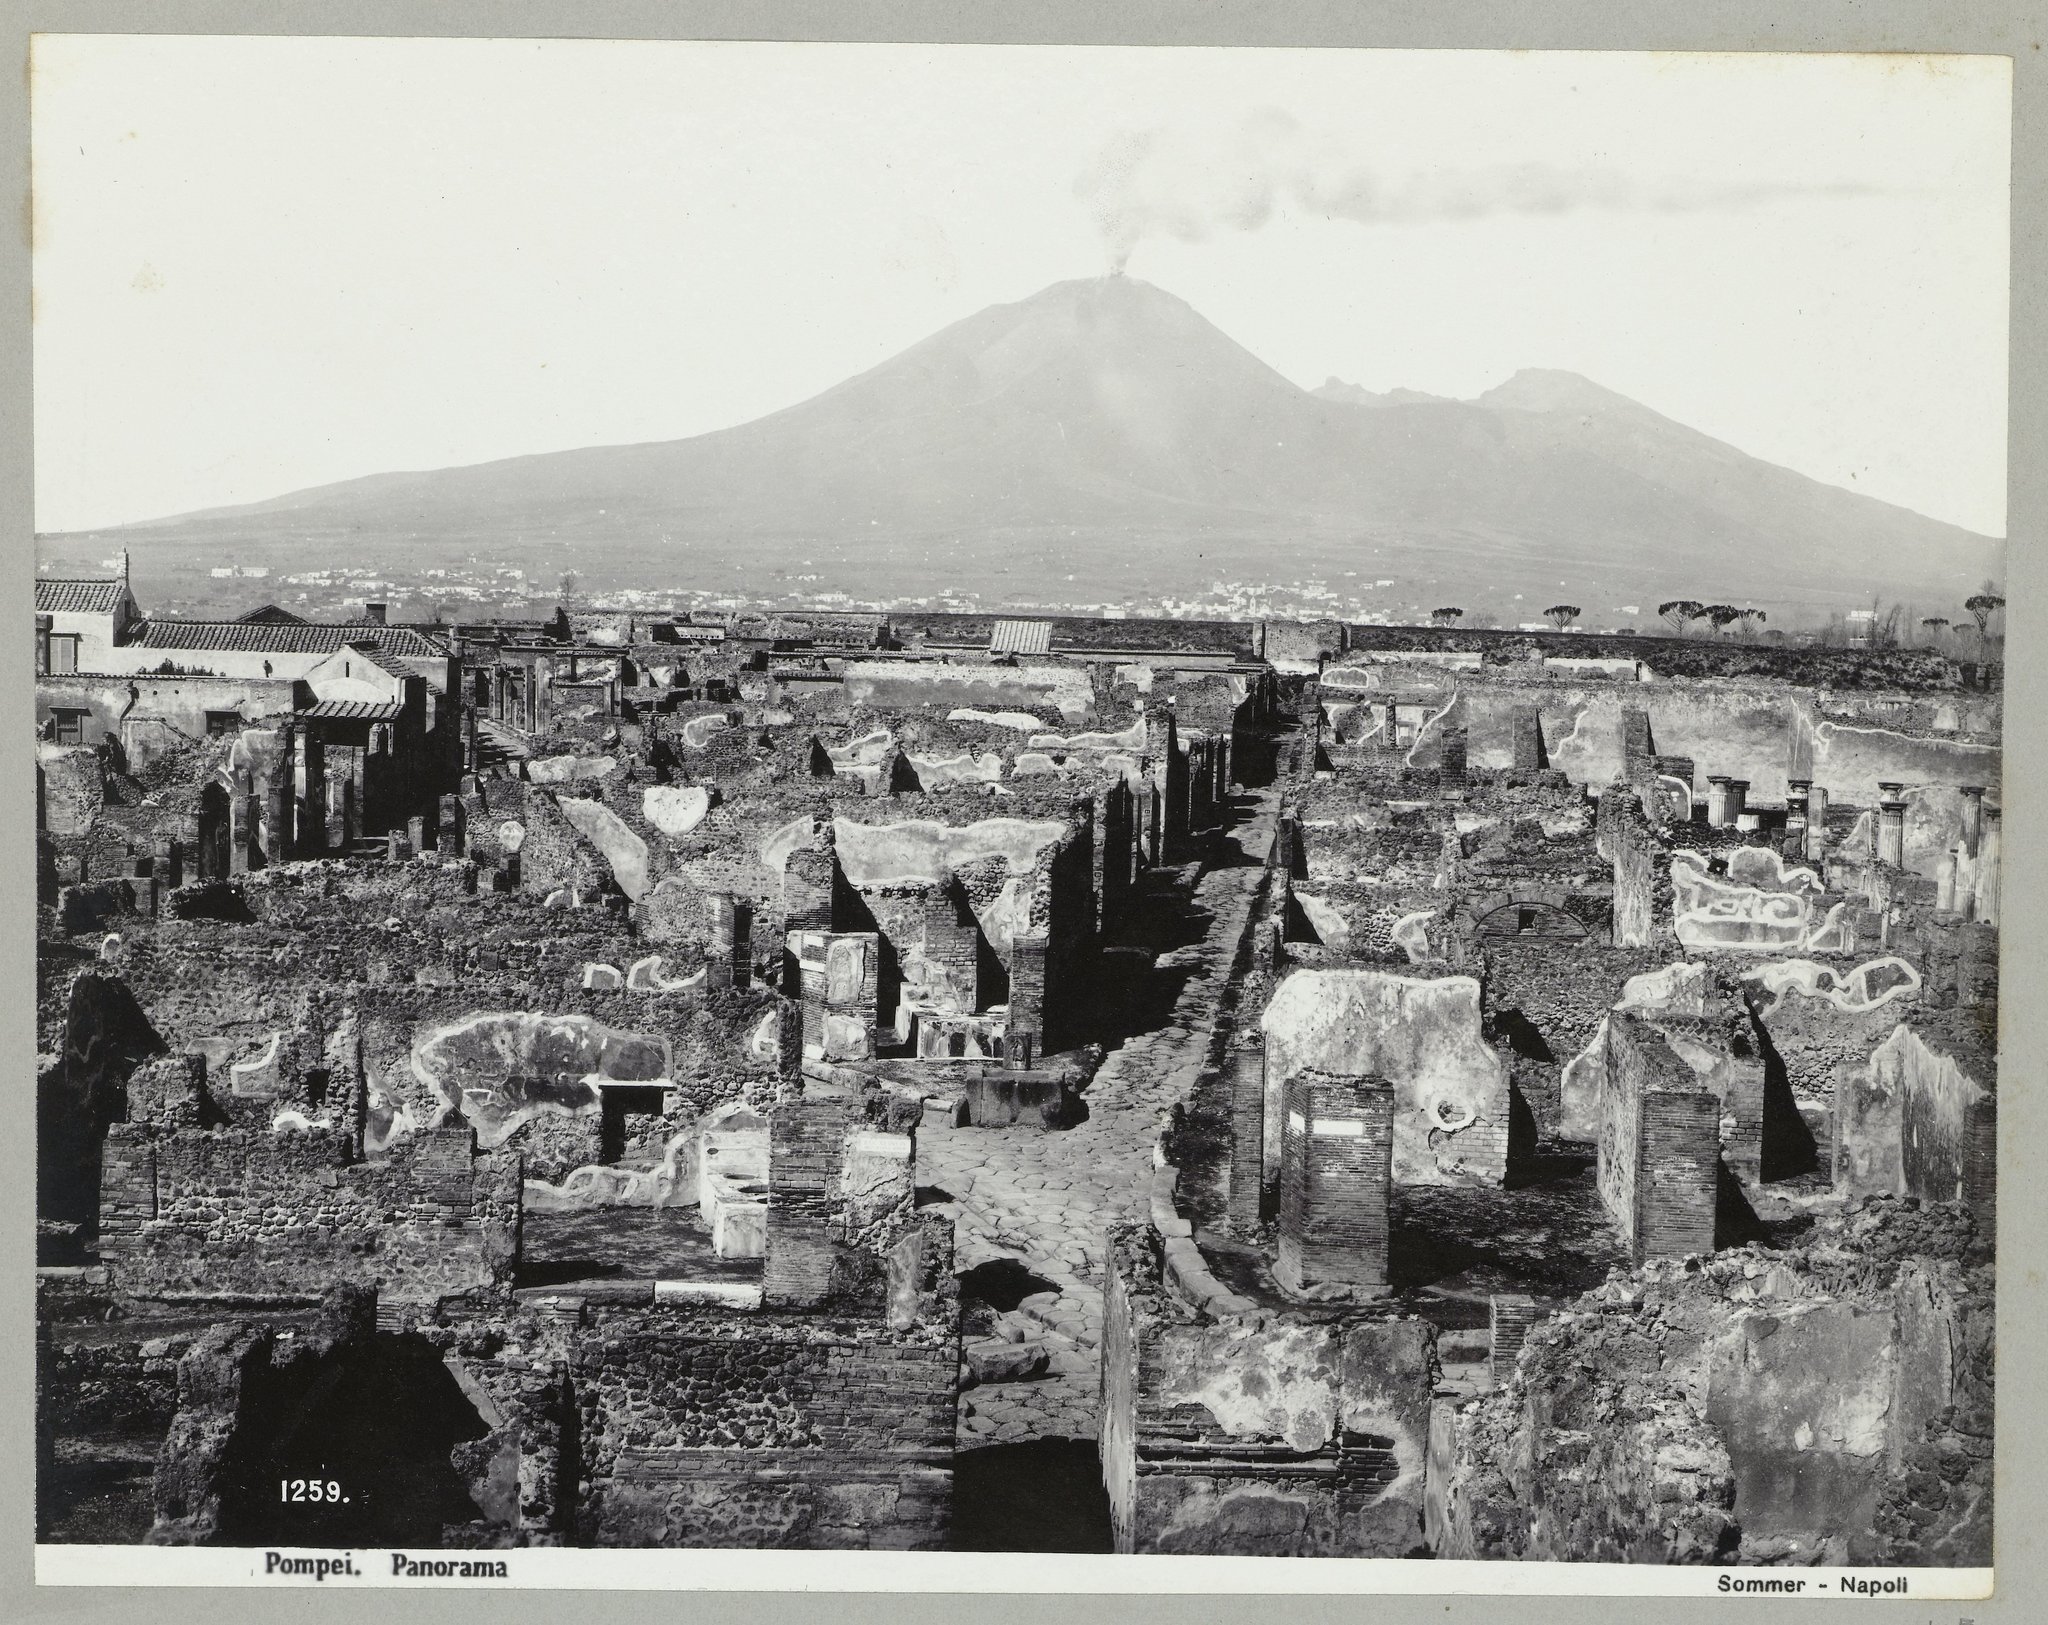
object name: photograph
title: 1259 Pompei panorama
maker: giorgio sommer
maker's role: fotograaf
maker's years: 1834-1914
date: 1888-1903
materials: cardboard, photographic support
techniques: albumen print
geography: netherlands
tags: pompeii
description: Een panorama over de overblijfselen van de stad Pompeï